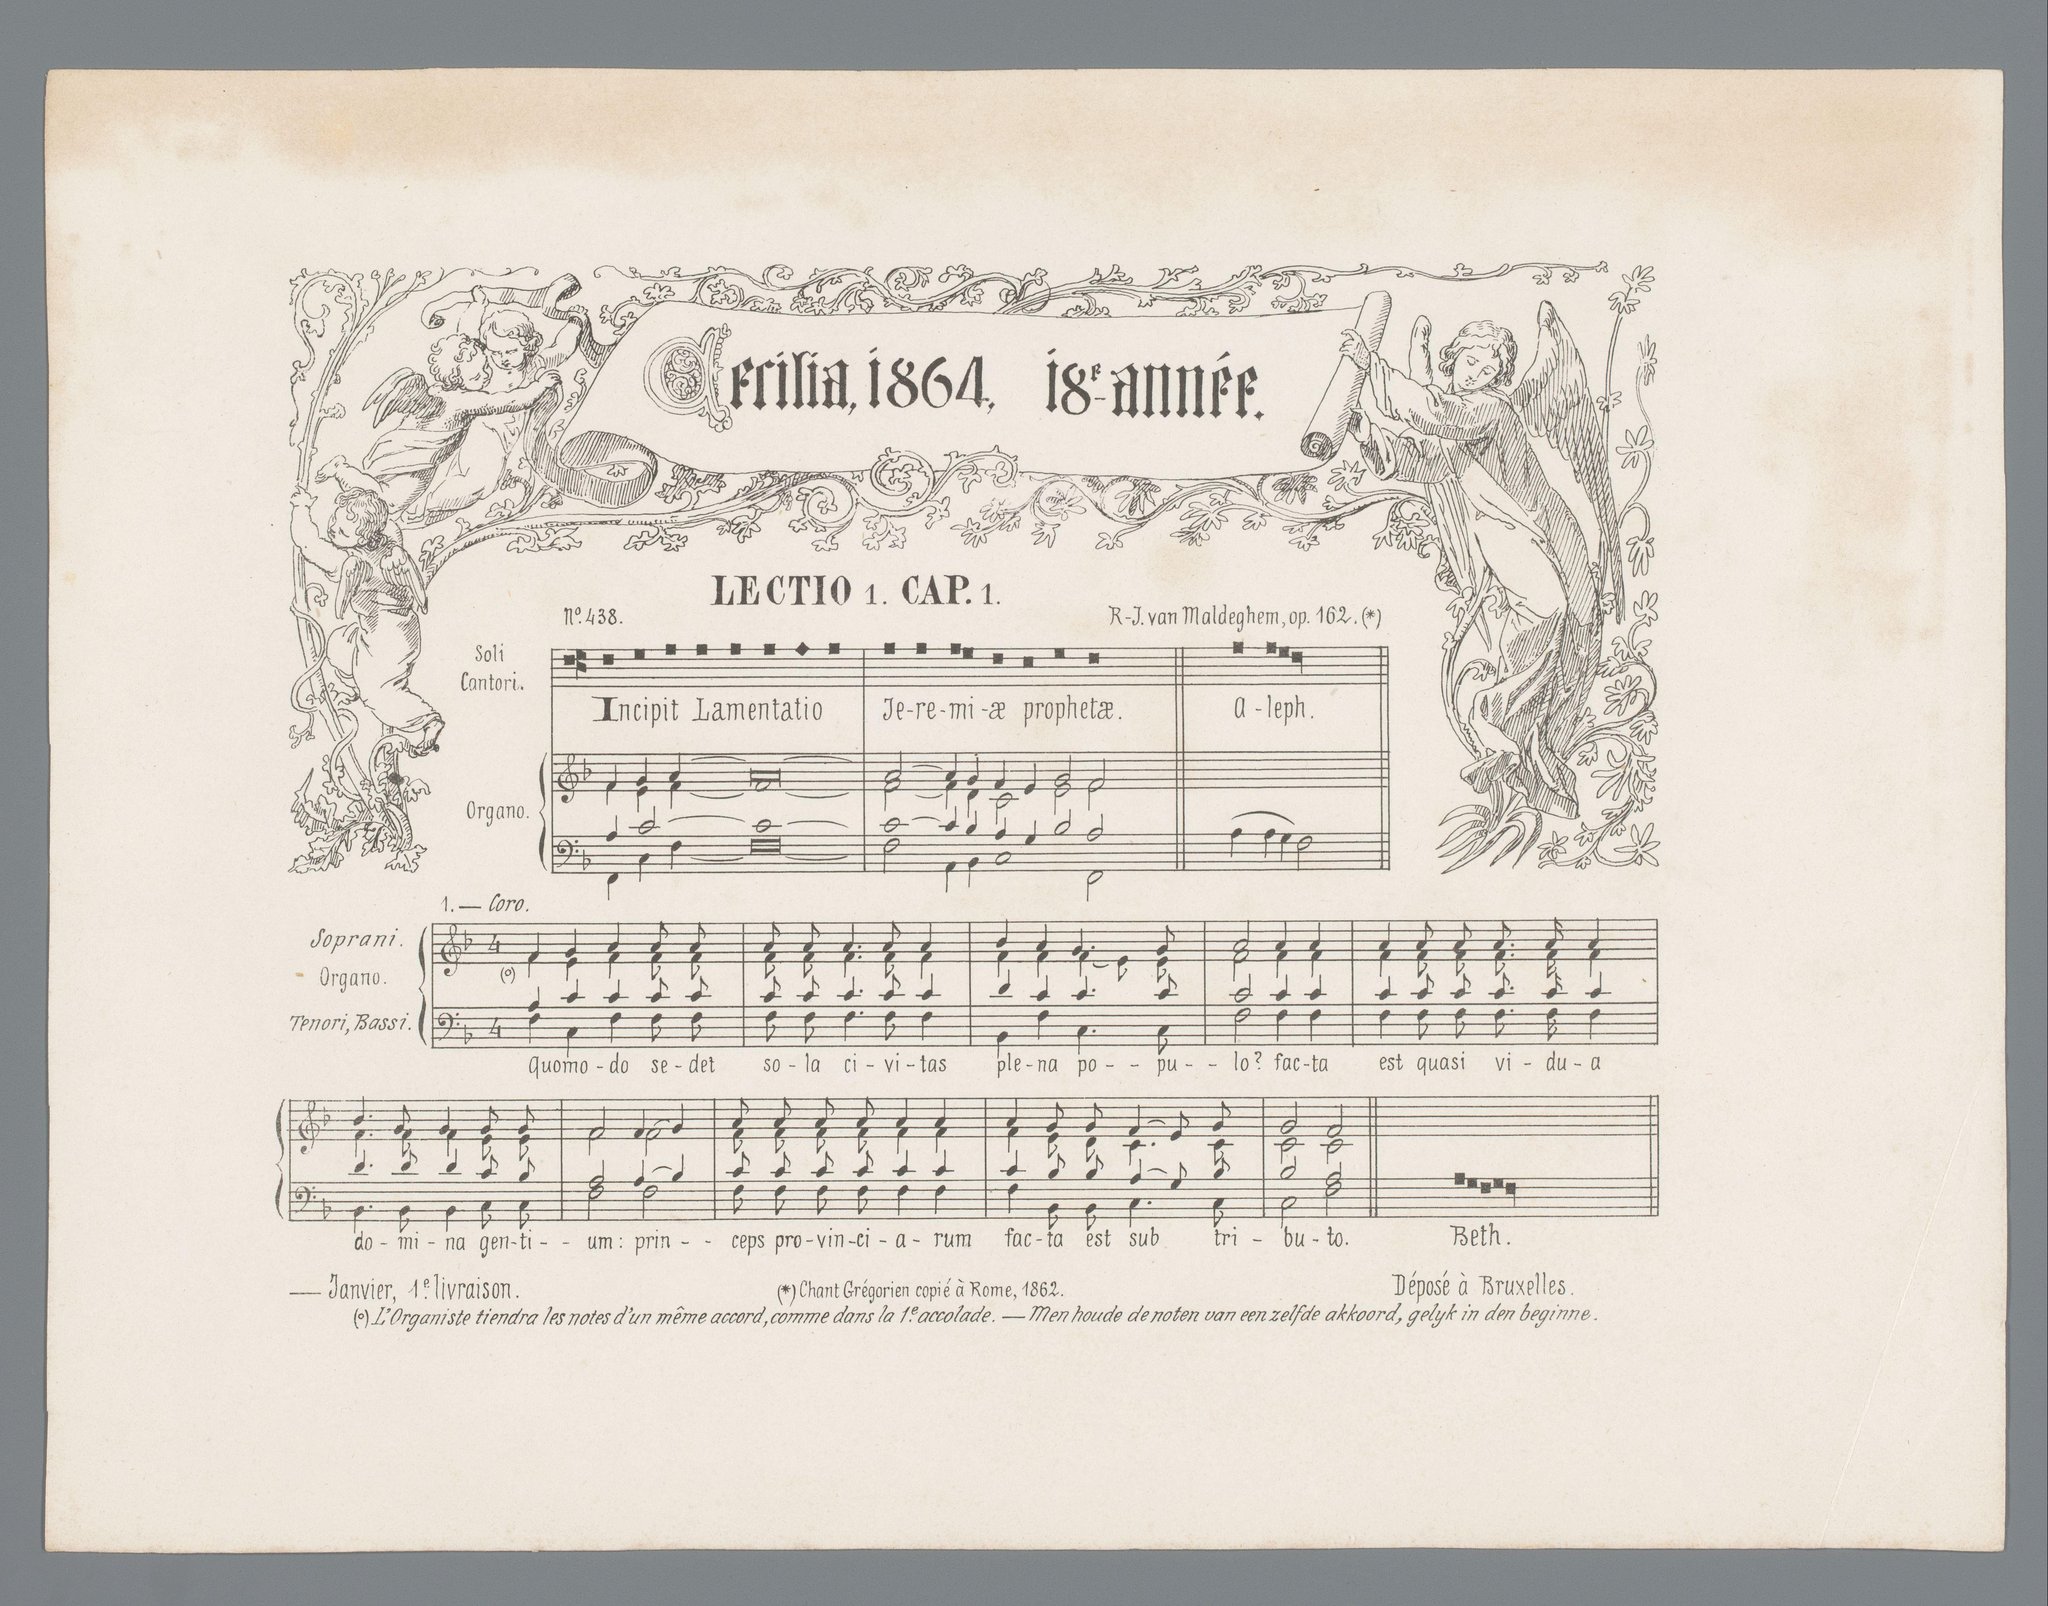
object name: muziekblad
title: Drie putti en een engel met banderol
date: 1864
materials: paper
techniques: lithograph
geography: brussels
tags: notation of music, cupids: 'amores', 'amoretti', 'putti', angels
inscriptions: collector's mark: Lugt 2228, inscription: ‘Déposé à Bruxelles’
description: Prent uit: Cecilia, journal mensuel de musique d'église 18 (1864), nr. 1.